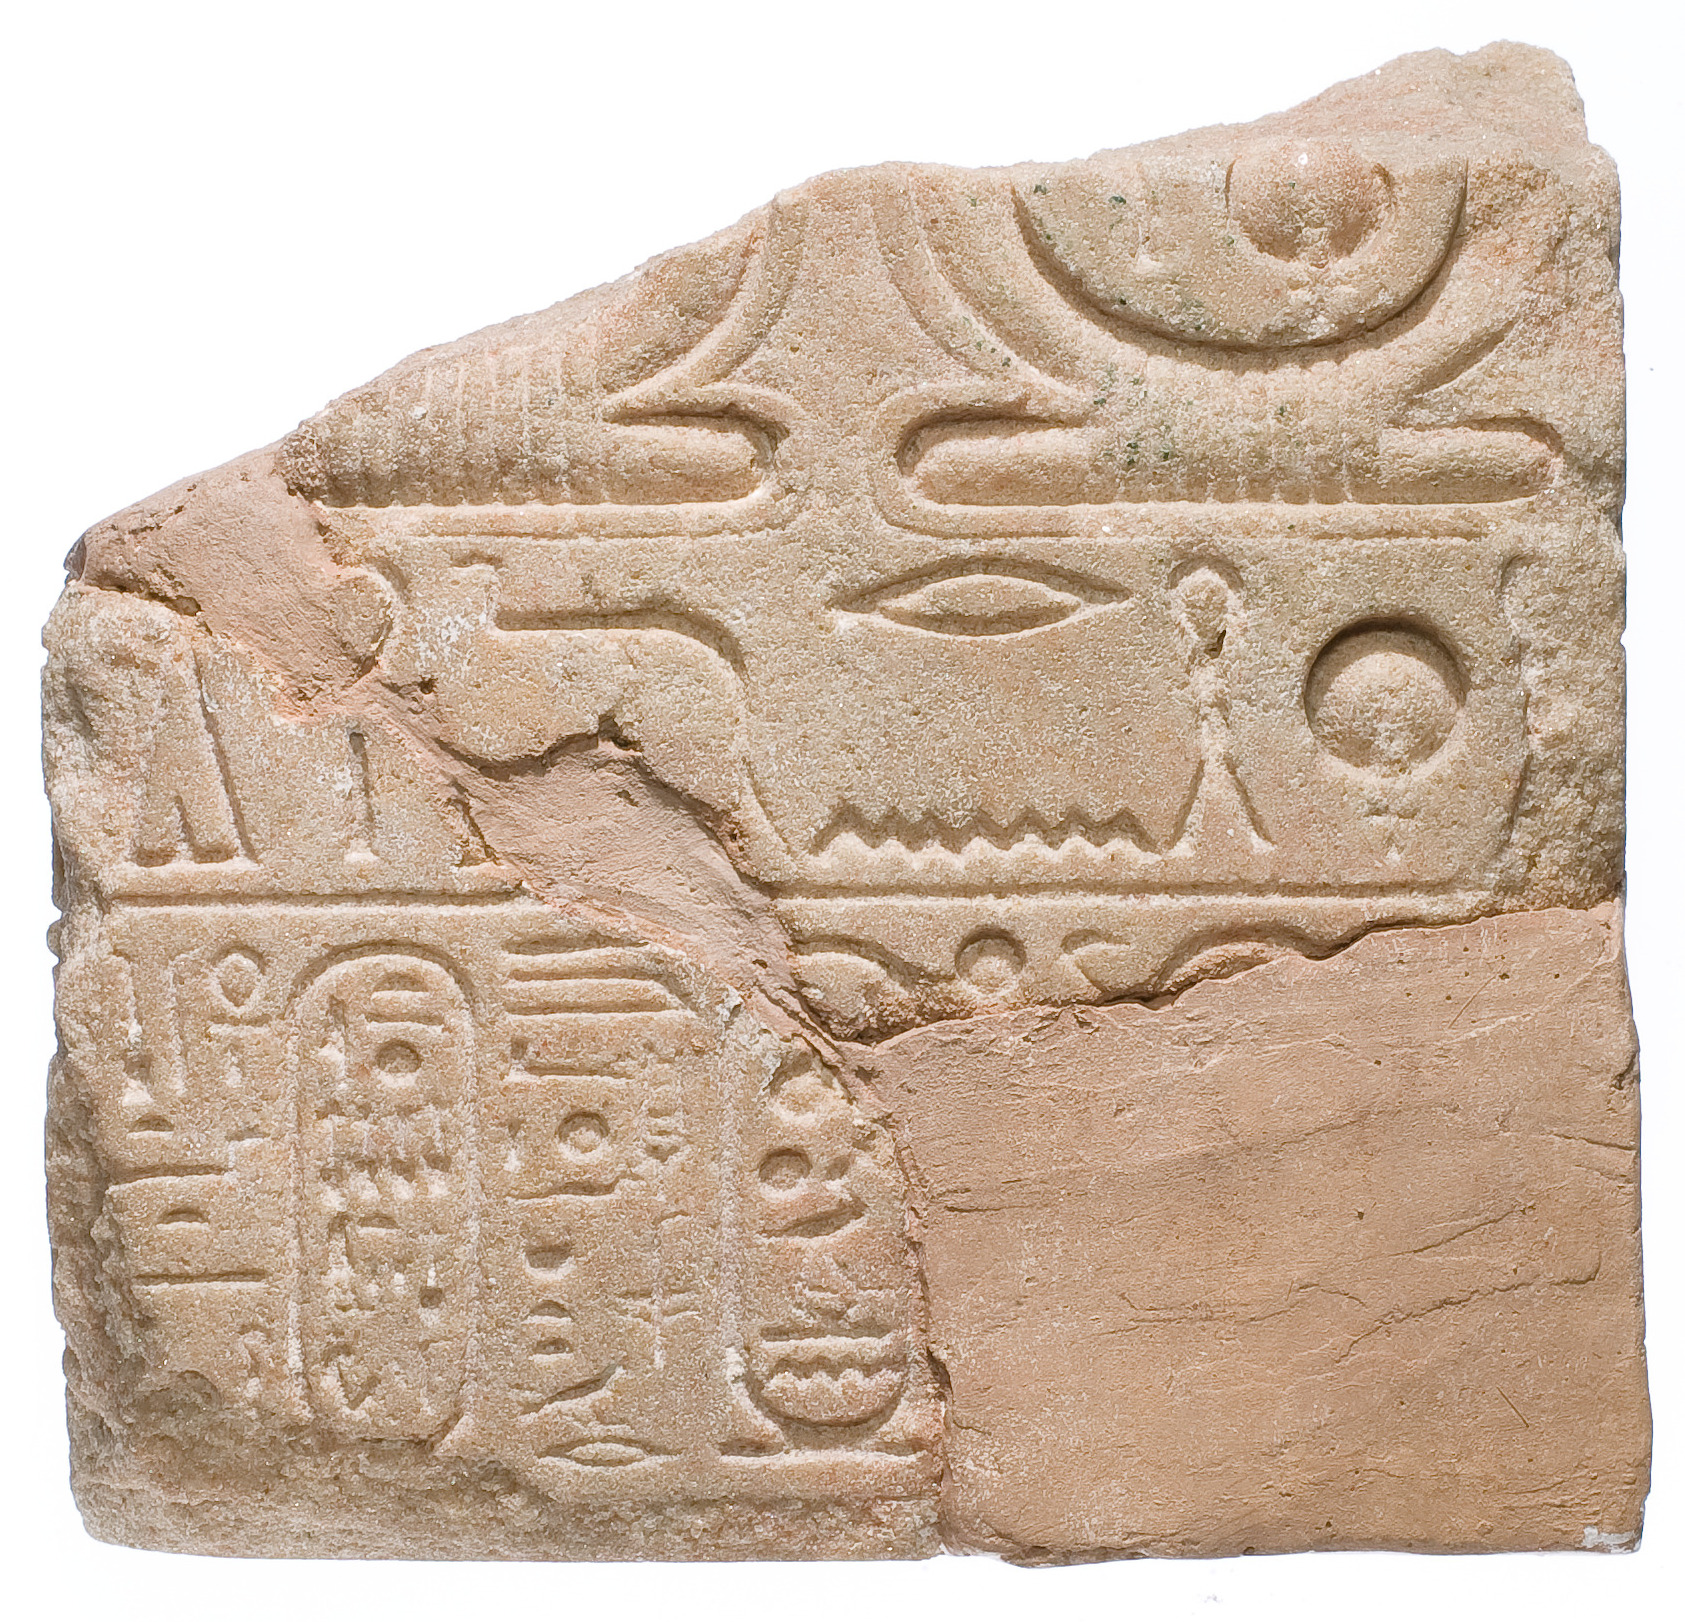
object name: tablet, cartouch of aten akhenaten, nefertiti cartouch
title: Tablet with cartouches of Aten, Akhenaten and Nefertiti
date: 1353-1336 BCE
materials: quartzite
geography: egypt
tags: cartouches,hieroglyphs